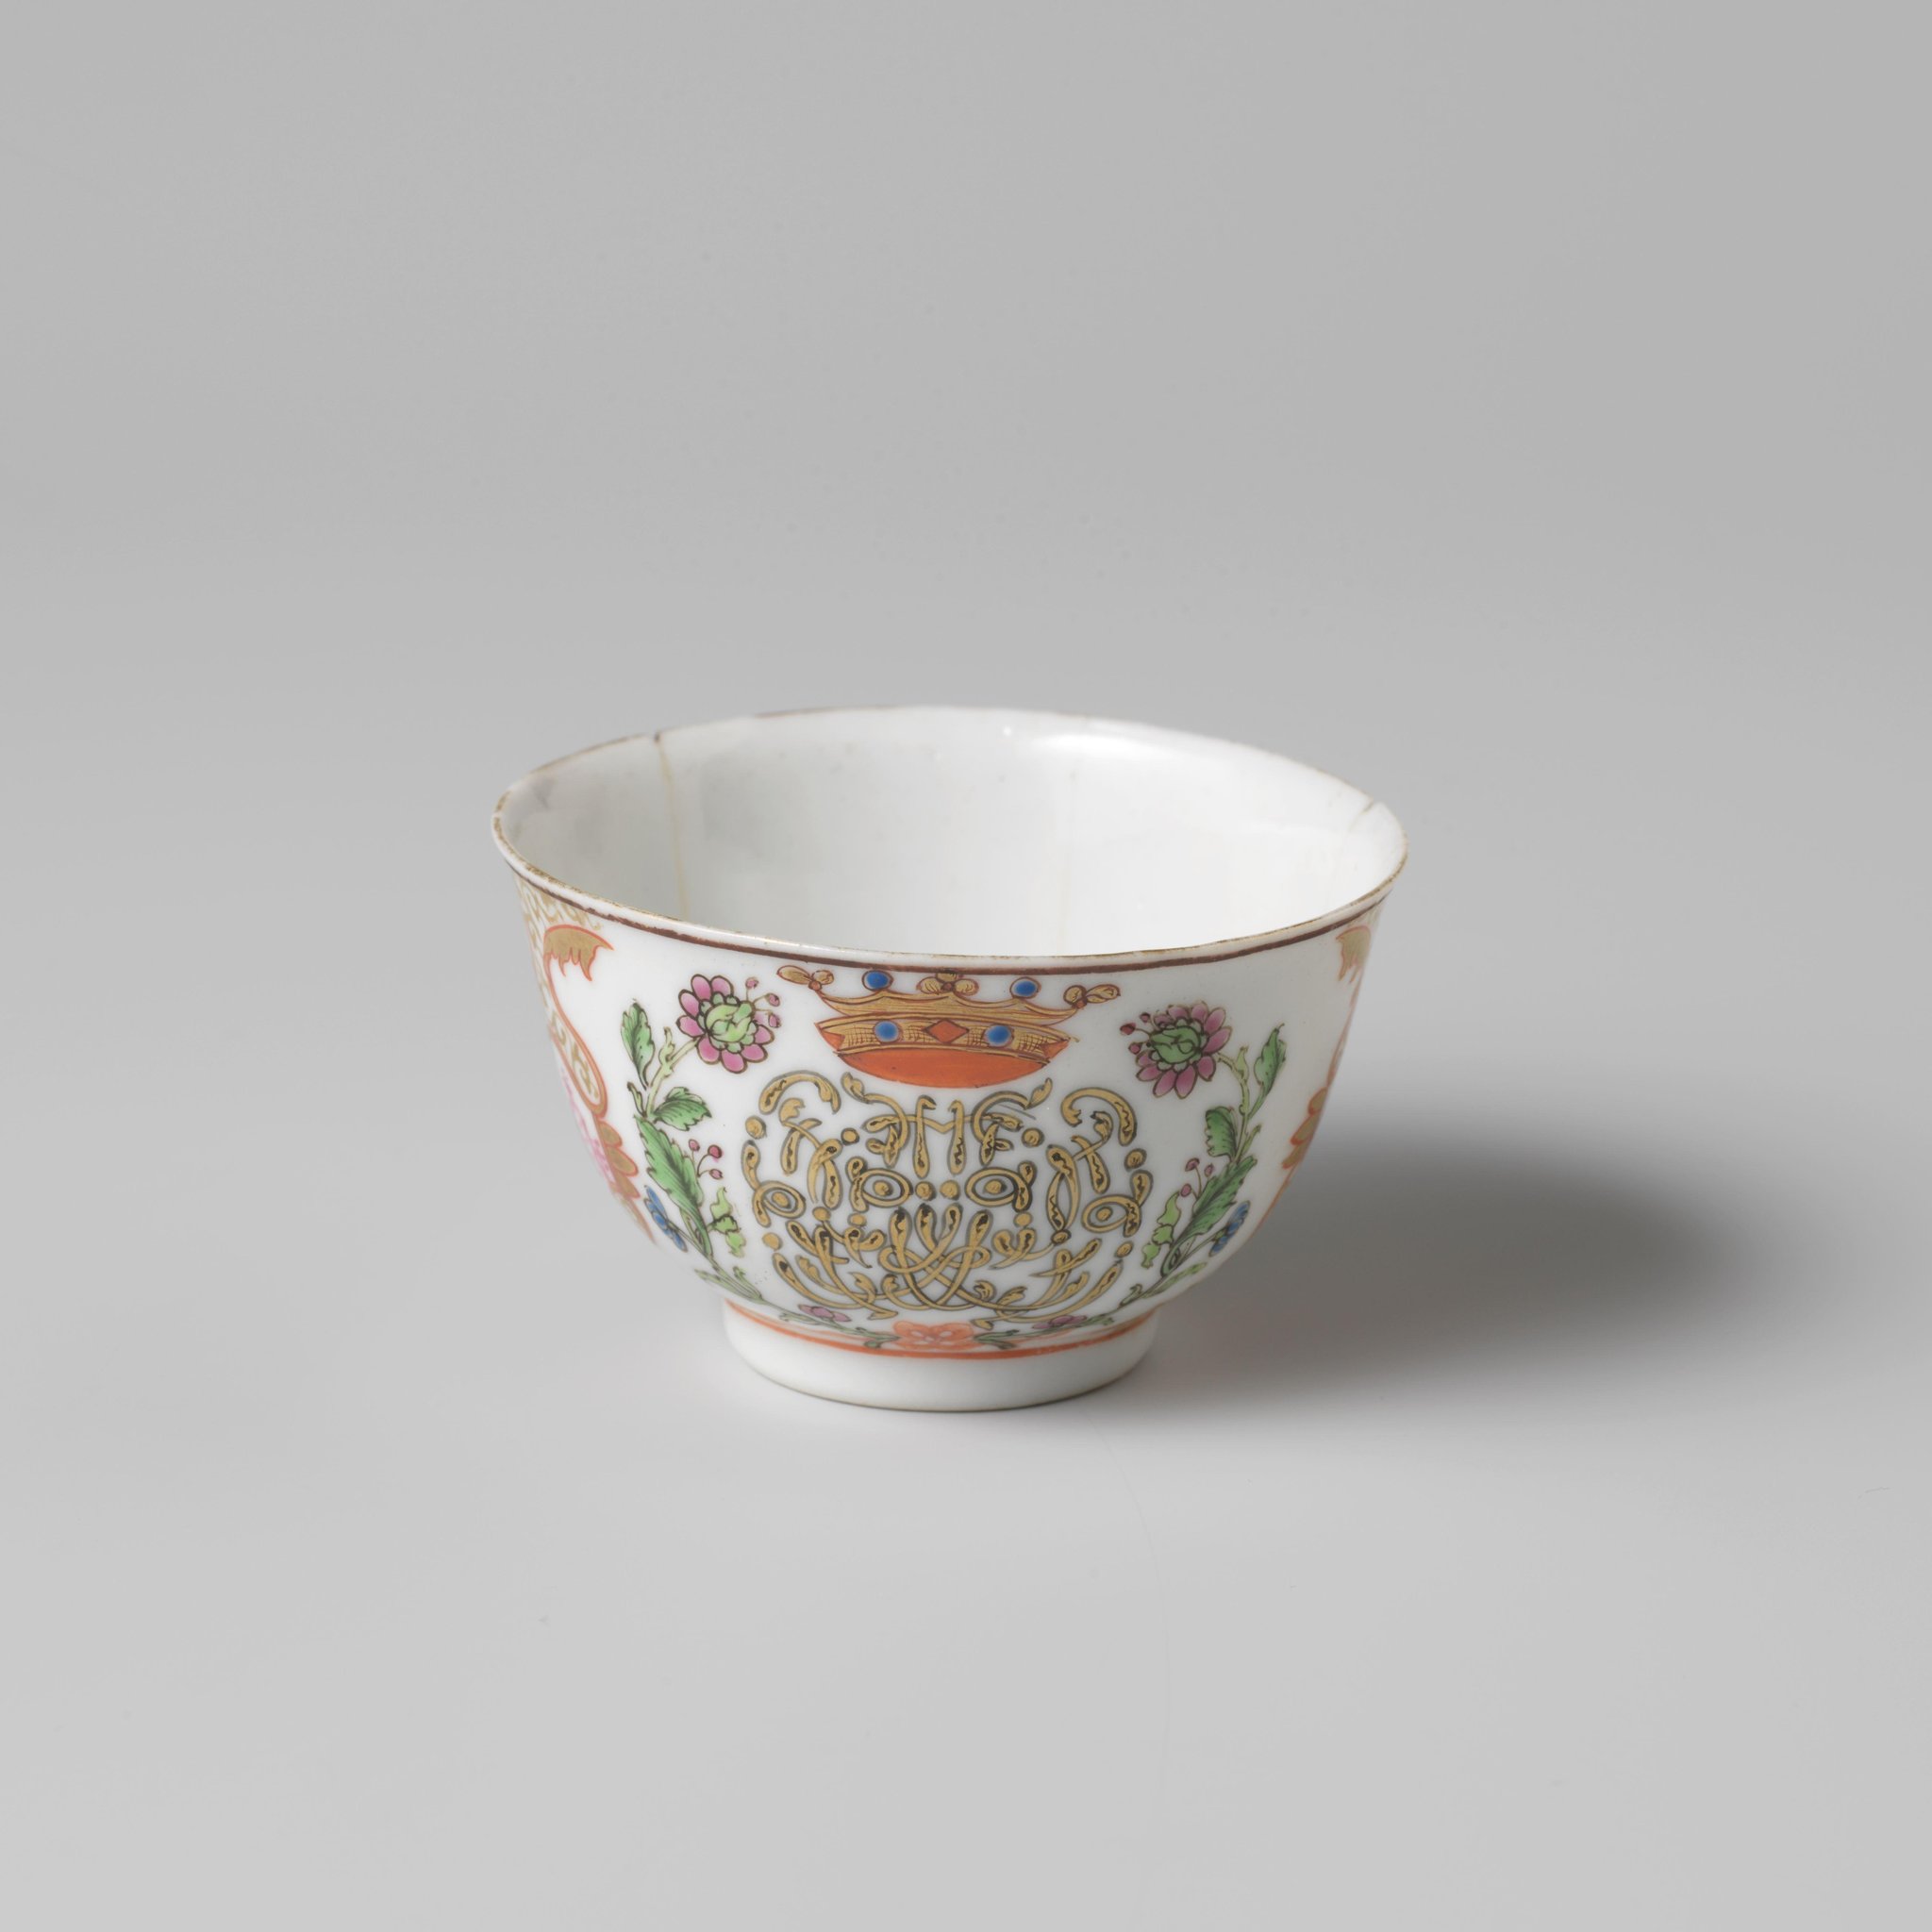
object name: cup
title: Bell-shaped cup with a crowned, illegible monogram surrounded by two flower sprays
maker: Anonymous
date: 1750-1774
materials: glaze, gold, paint, porcelain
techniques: firing, gilding, turning, vitrification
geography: china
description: Klokvormige kop van porselein, beschilderd op het glazuur in blauw, rood, roze, groen, geel, zwart en goud. Op de buitenwand tweemaal een gekroond, onleesbaar monogram omringd door twee bloemtakken; hiertussen bloemranken met daarin uitgespaard twee cartouches met een landschap en vier medaillons met planten. Vier barsten in de wand van de kop. Europese voorstelling in emailkleuren.